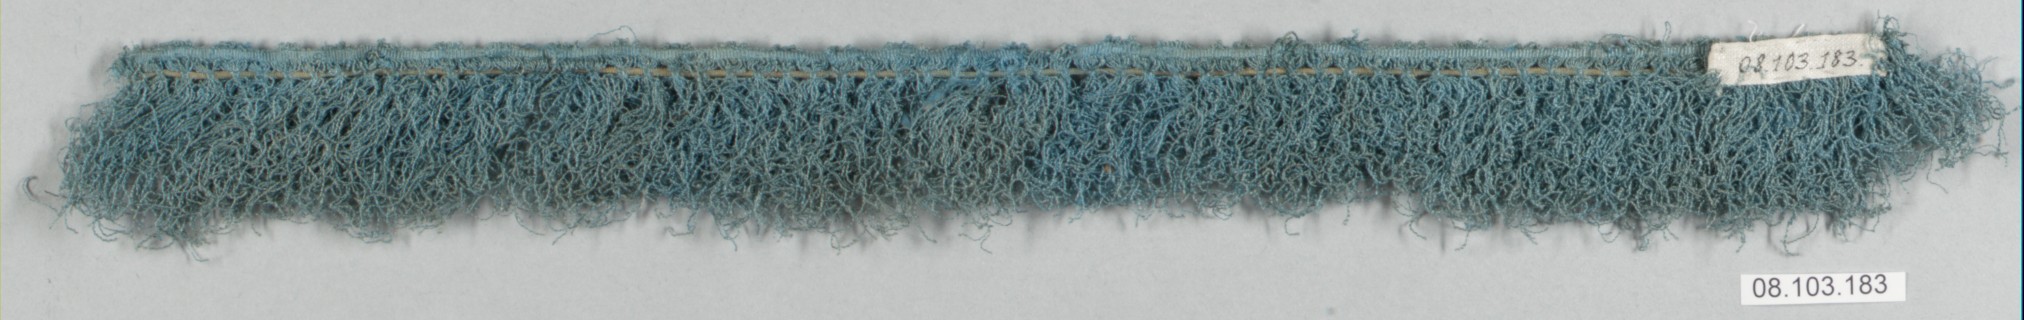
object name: fringe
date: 1801-1900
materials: silk